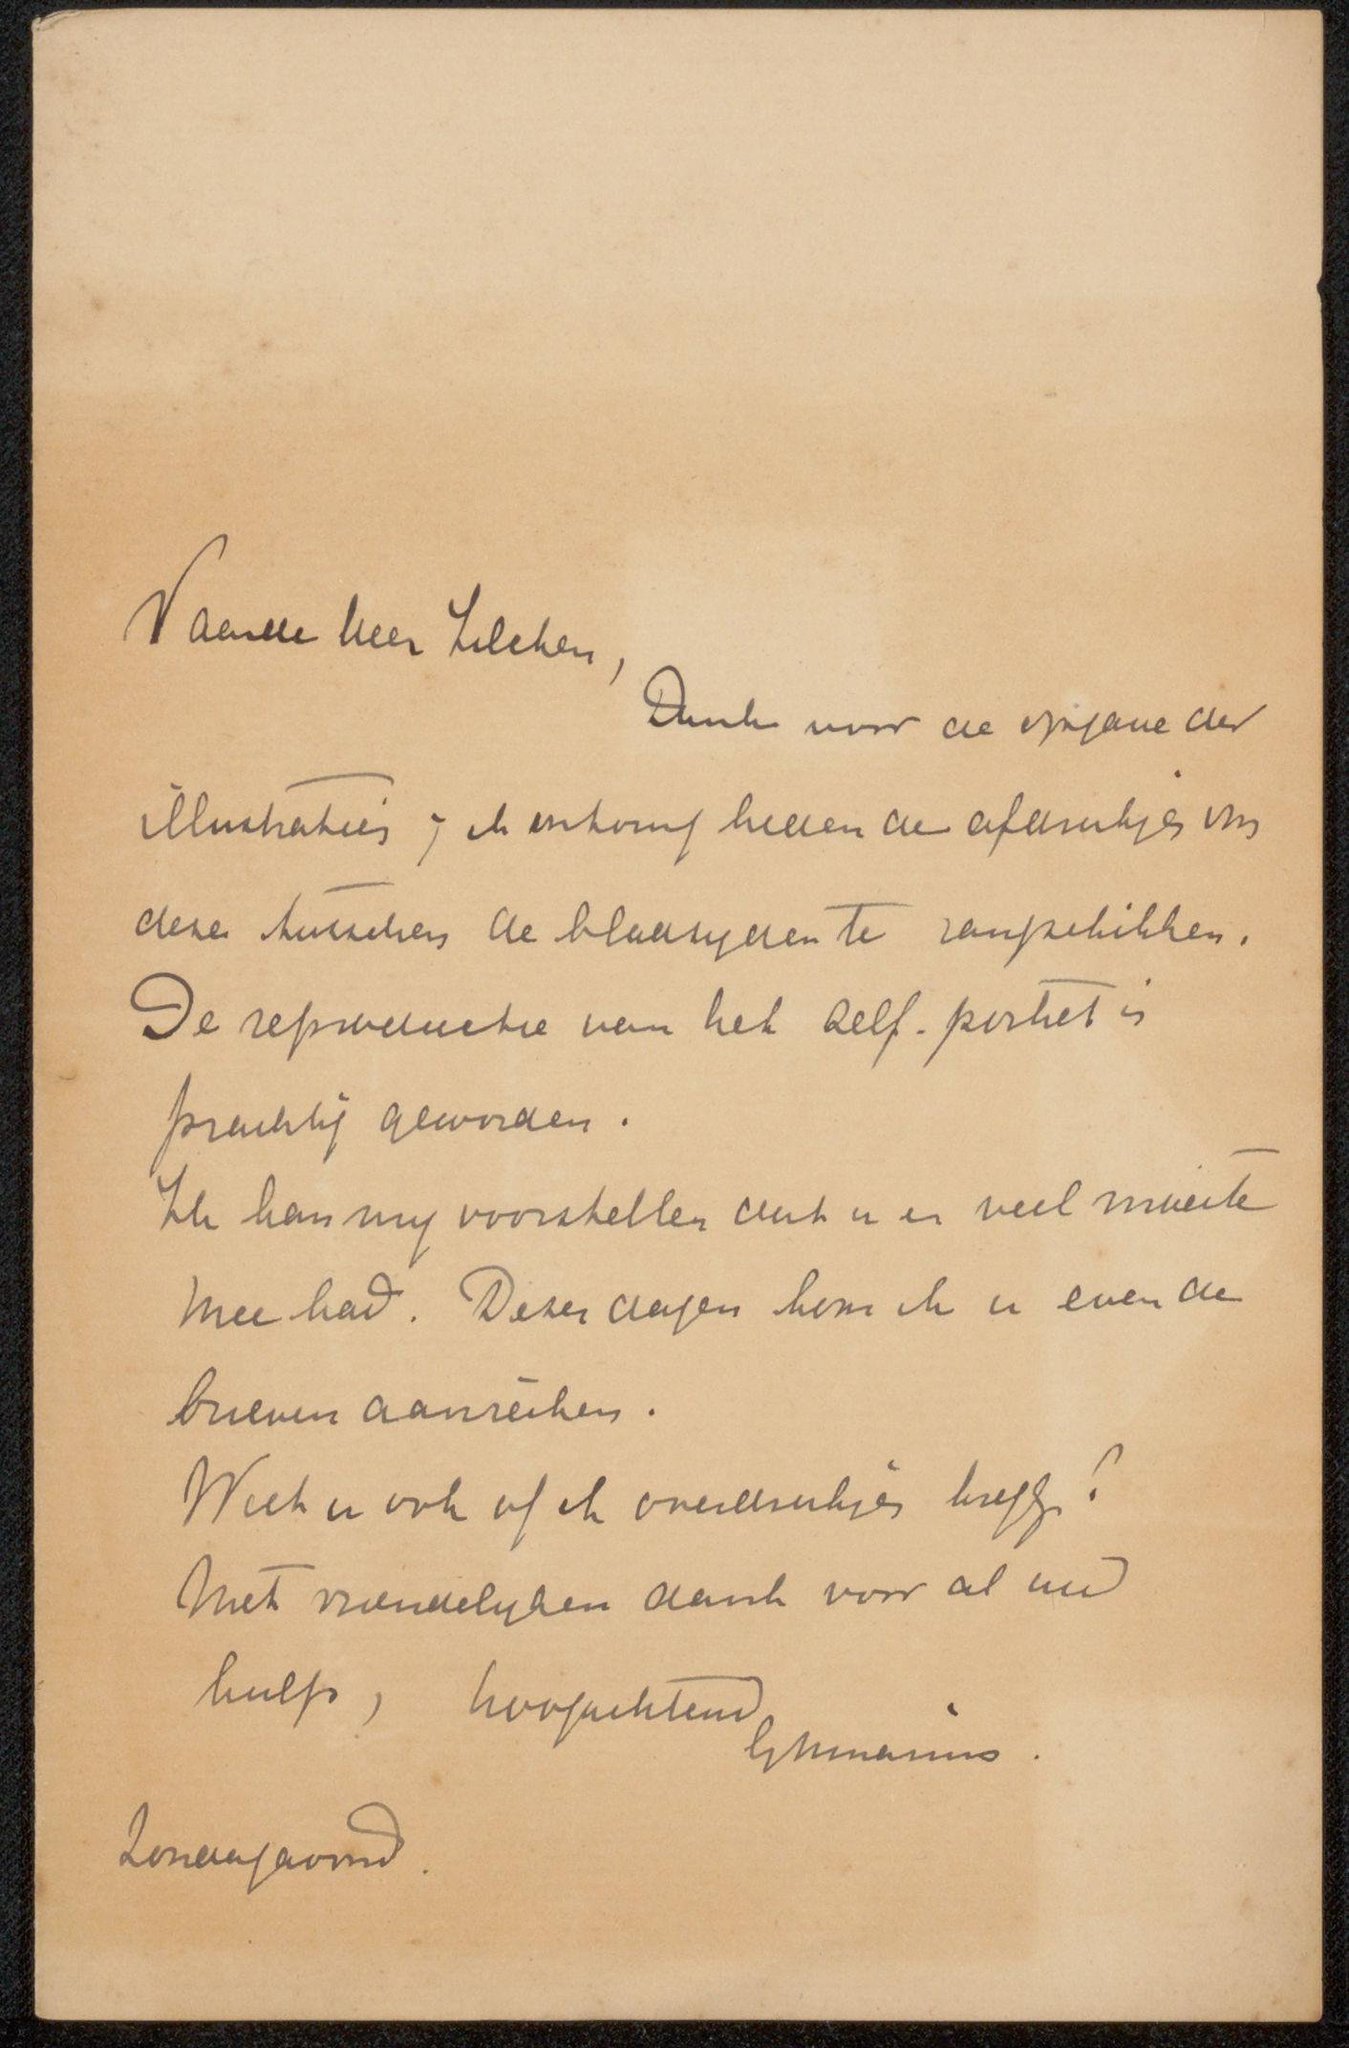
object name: letter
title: Brief aan Philip Zilcken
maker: grada hermina marius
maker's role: painter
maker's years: 1854-1919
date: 1864-1919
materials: ink, paper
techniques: pen, writing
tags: the hague, painter, draughtsman, philip zilcken, illustration ~ printed matter, book, historical persons (portraits and scenes from the life)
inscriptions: collector's mark: ‘RPK’